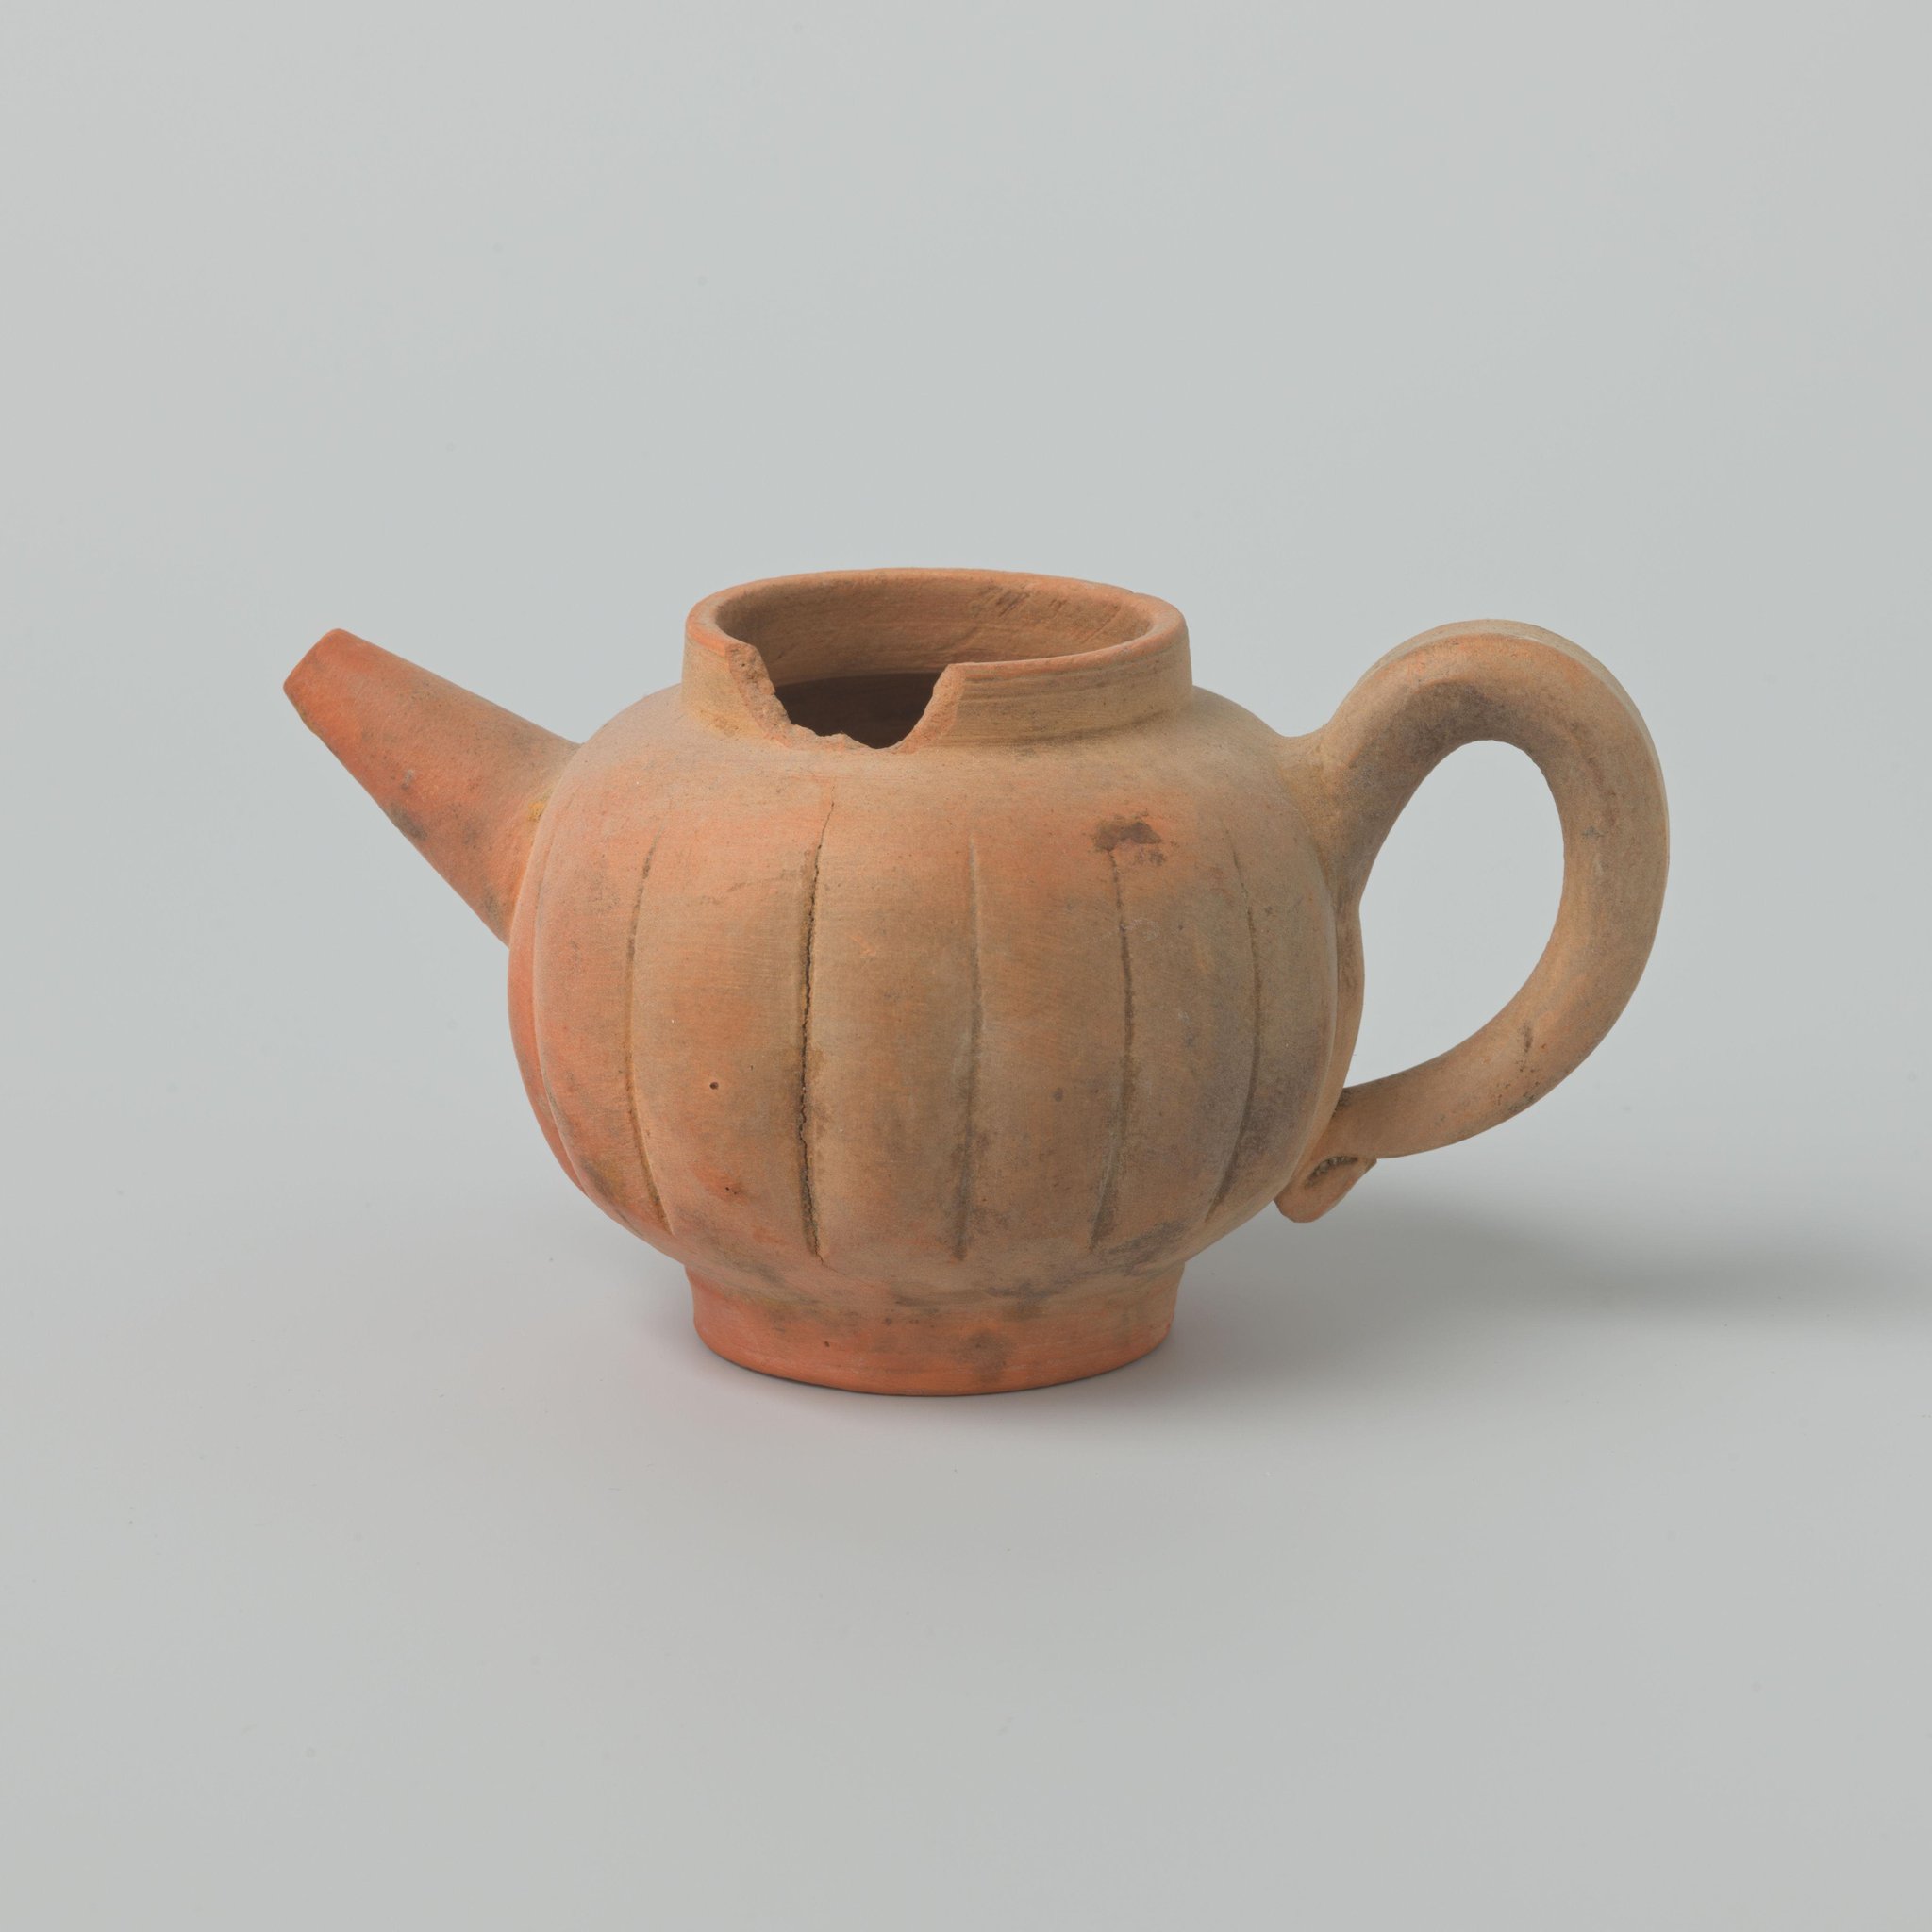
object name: teapot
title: Theepot met gelobde wand (De Caluwe bakafval)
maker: jacobus de caluwe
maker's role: plateelbakkerij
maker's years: -1730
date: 1700-1725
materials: earthenware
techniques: firing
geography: delft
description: Toegeschreven aan Jacobus de Caluwe, omdat dit voorwerp samen met gemerkte stukken (‘Jacobus De Caluwe’ en rennend hert) gevonden is op de plaats waar zich De Caluwes tweede werkplaats bevond. Er is een duidelijke stilistische overeenkomst tussen de gemerkte en niet gemerkte voorwerpen uit deze archeologische vondst.